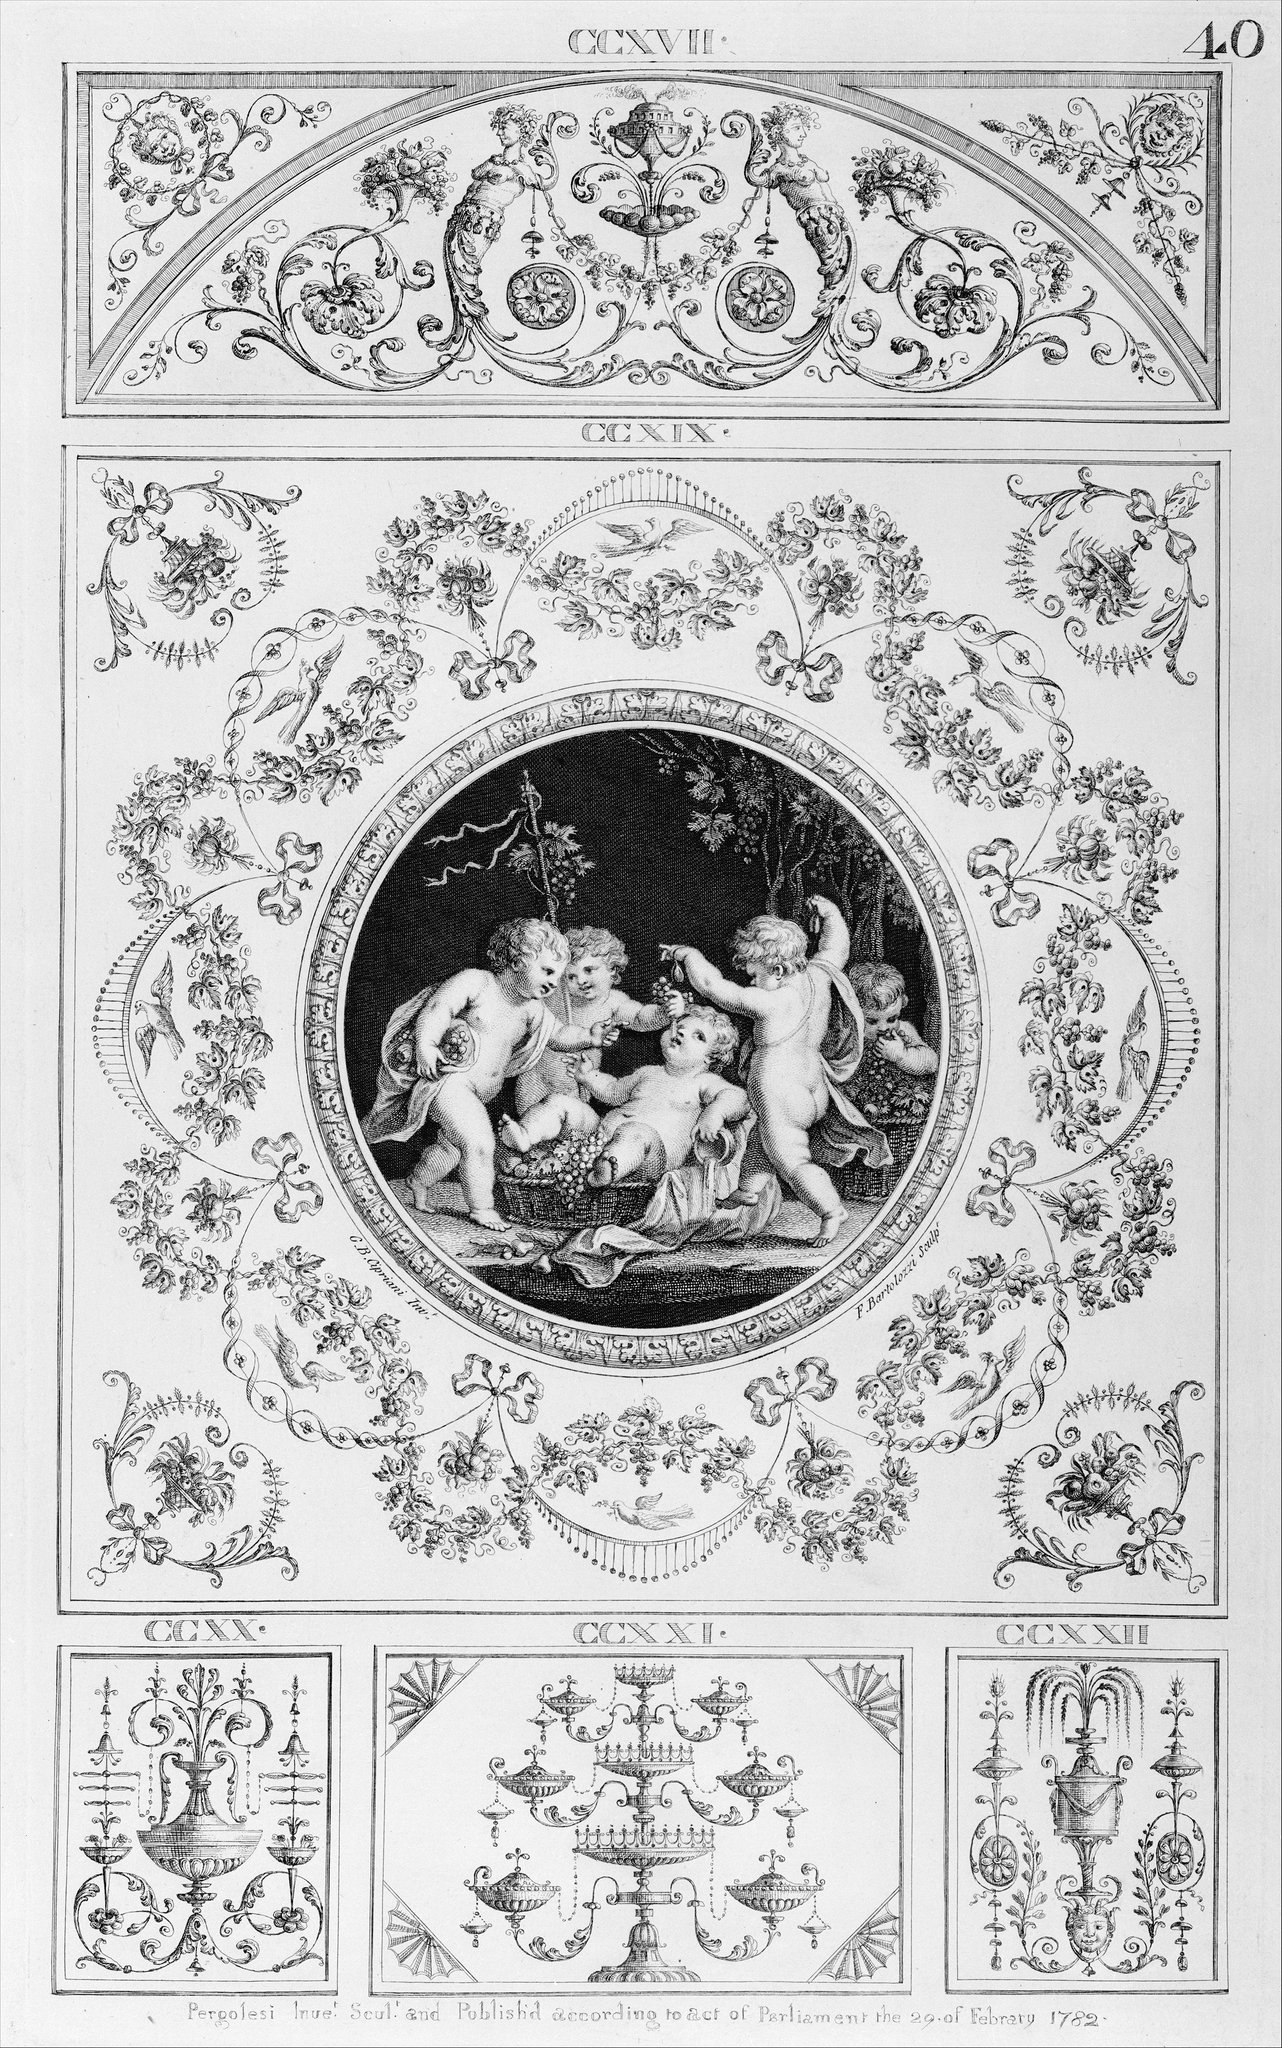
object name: print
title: Bacchanal with Five Putti, Rondel in a Rectangular Frame (in "Designs for Various Ornaments," pl. 40)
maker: francesco bartolozzi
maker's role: artist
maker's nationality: italian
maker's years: 1728-1815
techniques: etching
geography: england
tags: grapes